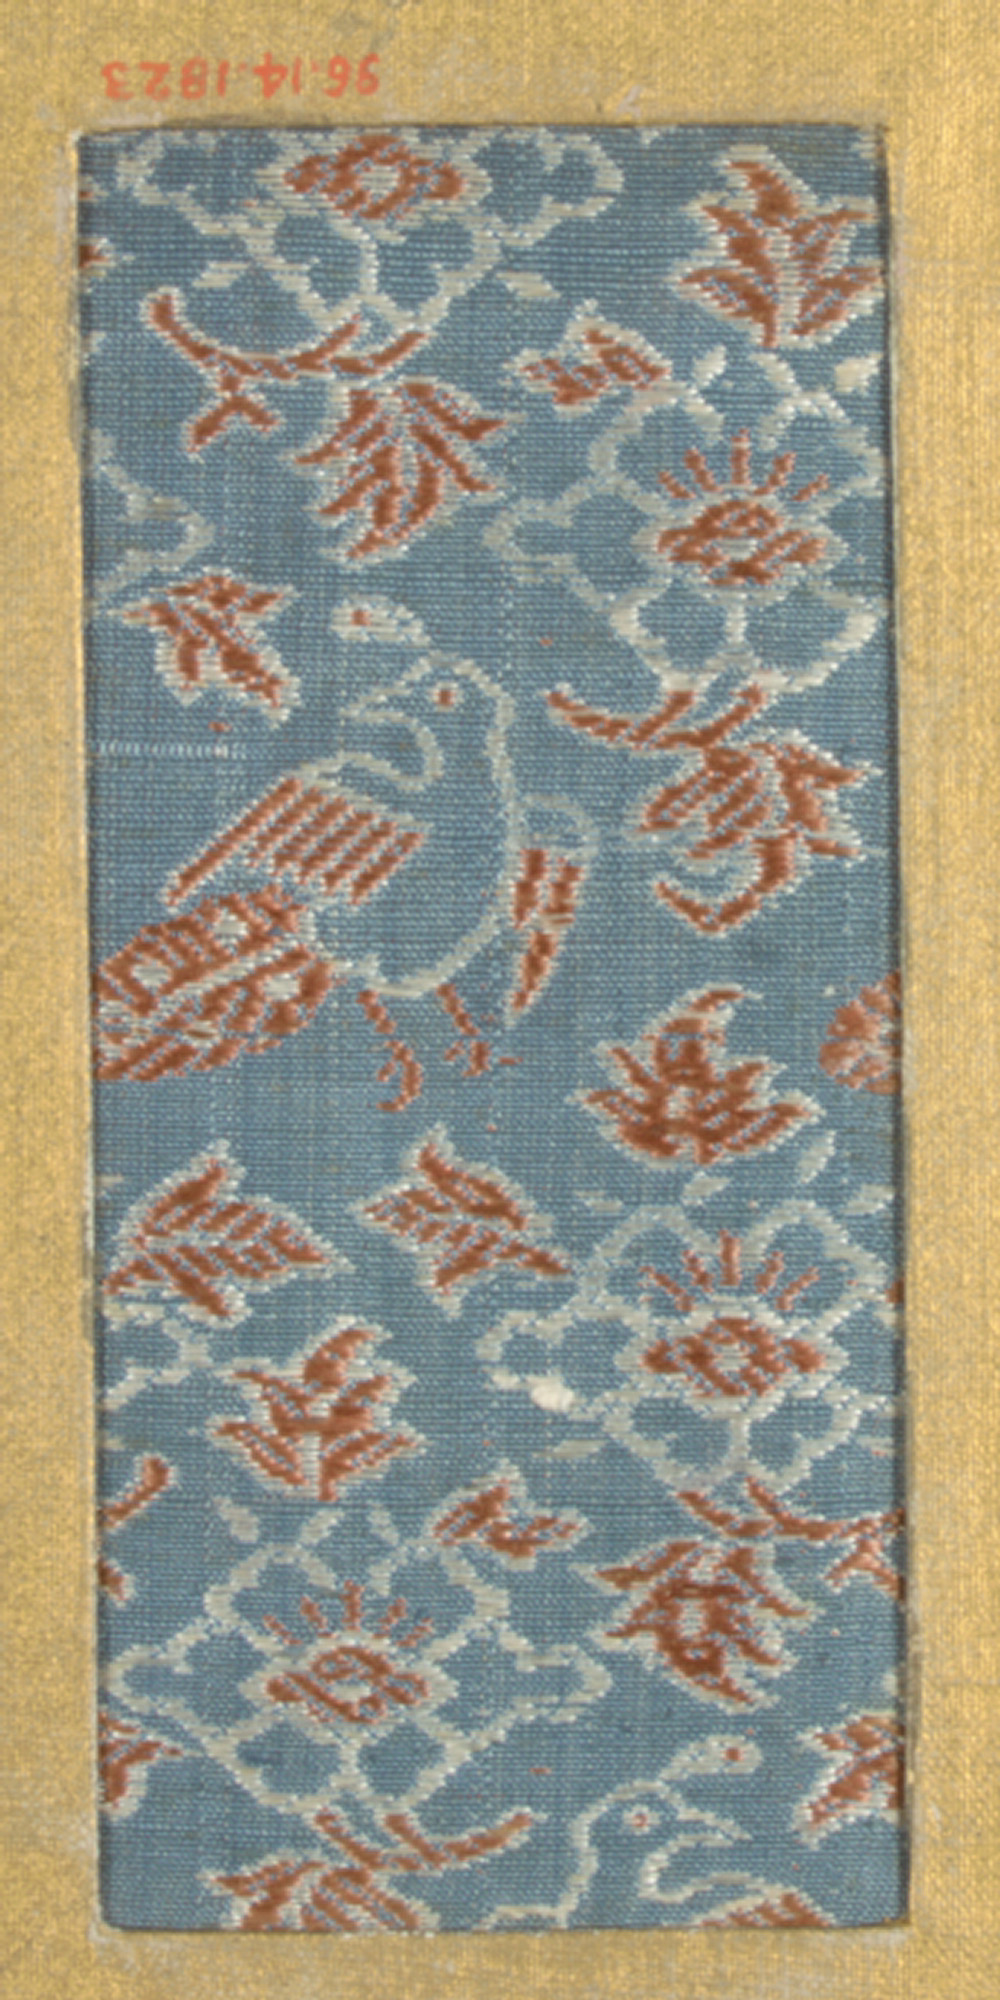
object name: piece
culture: japanese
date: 1701-1900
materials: silk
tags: leaves